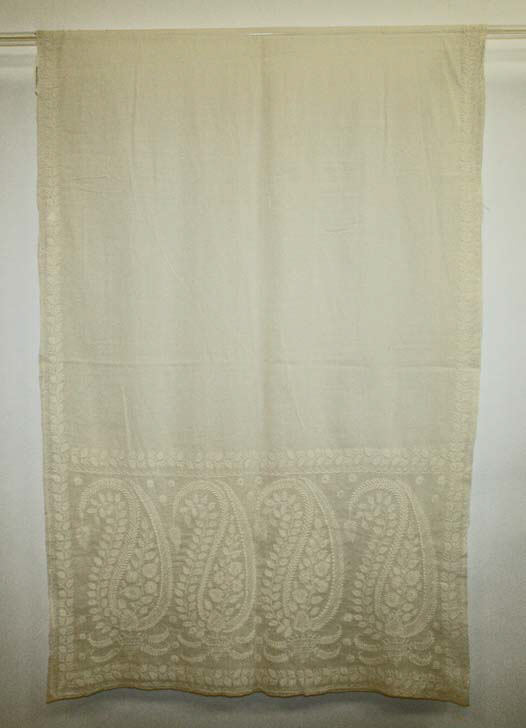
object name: scarf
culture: american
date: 1801-1833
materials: cotton